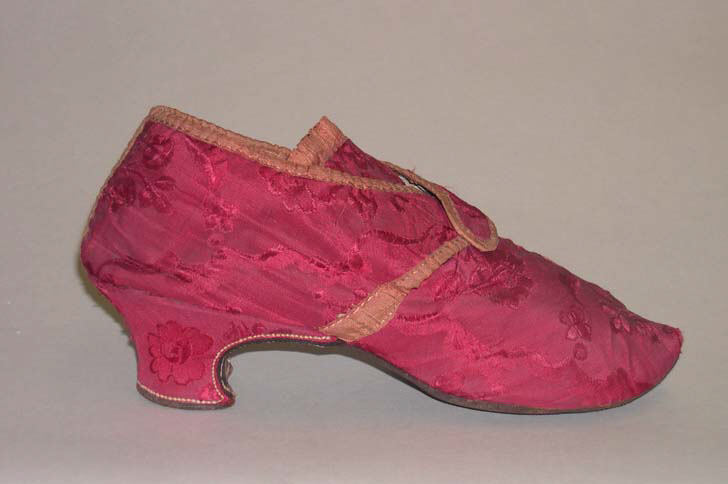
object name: shoe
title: Shoes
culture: italian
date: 1770-1789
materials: silk